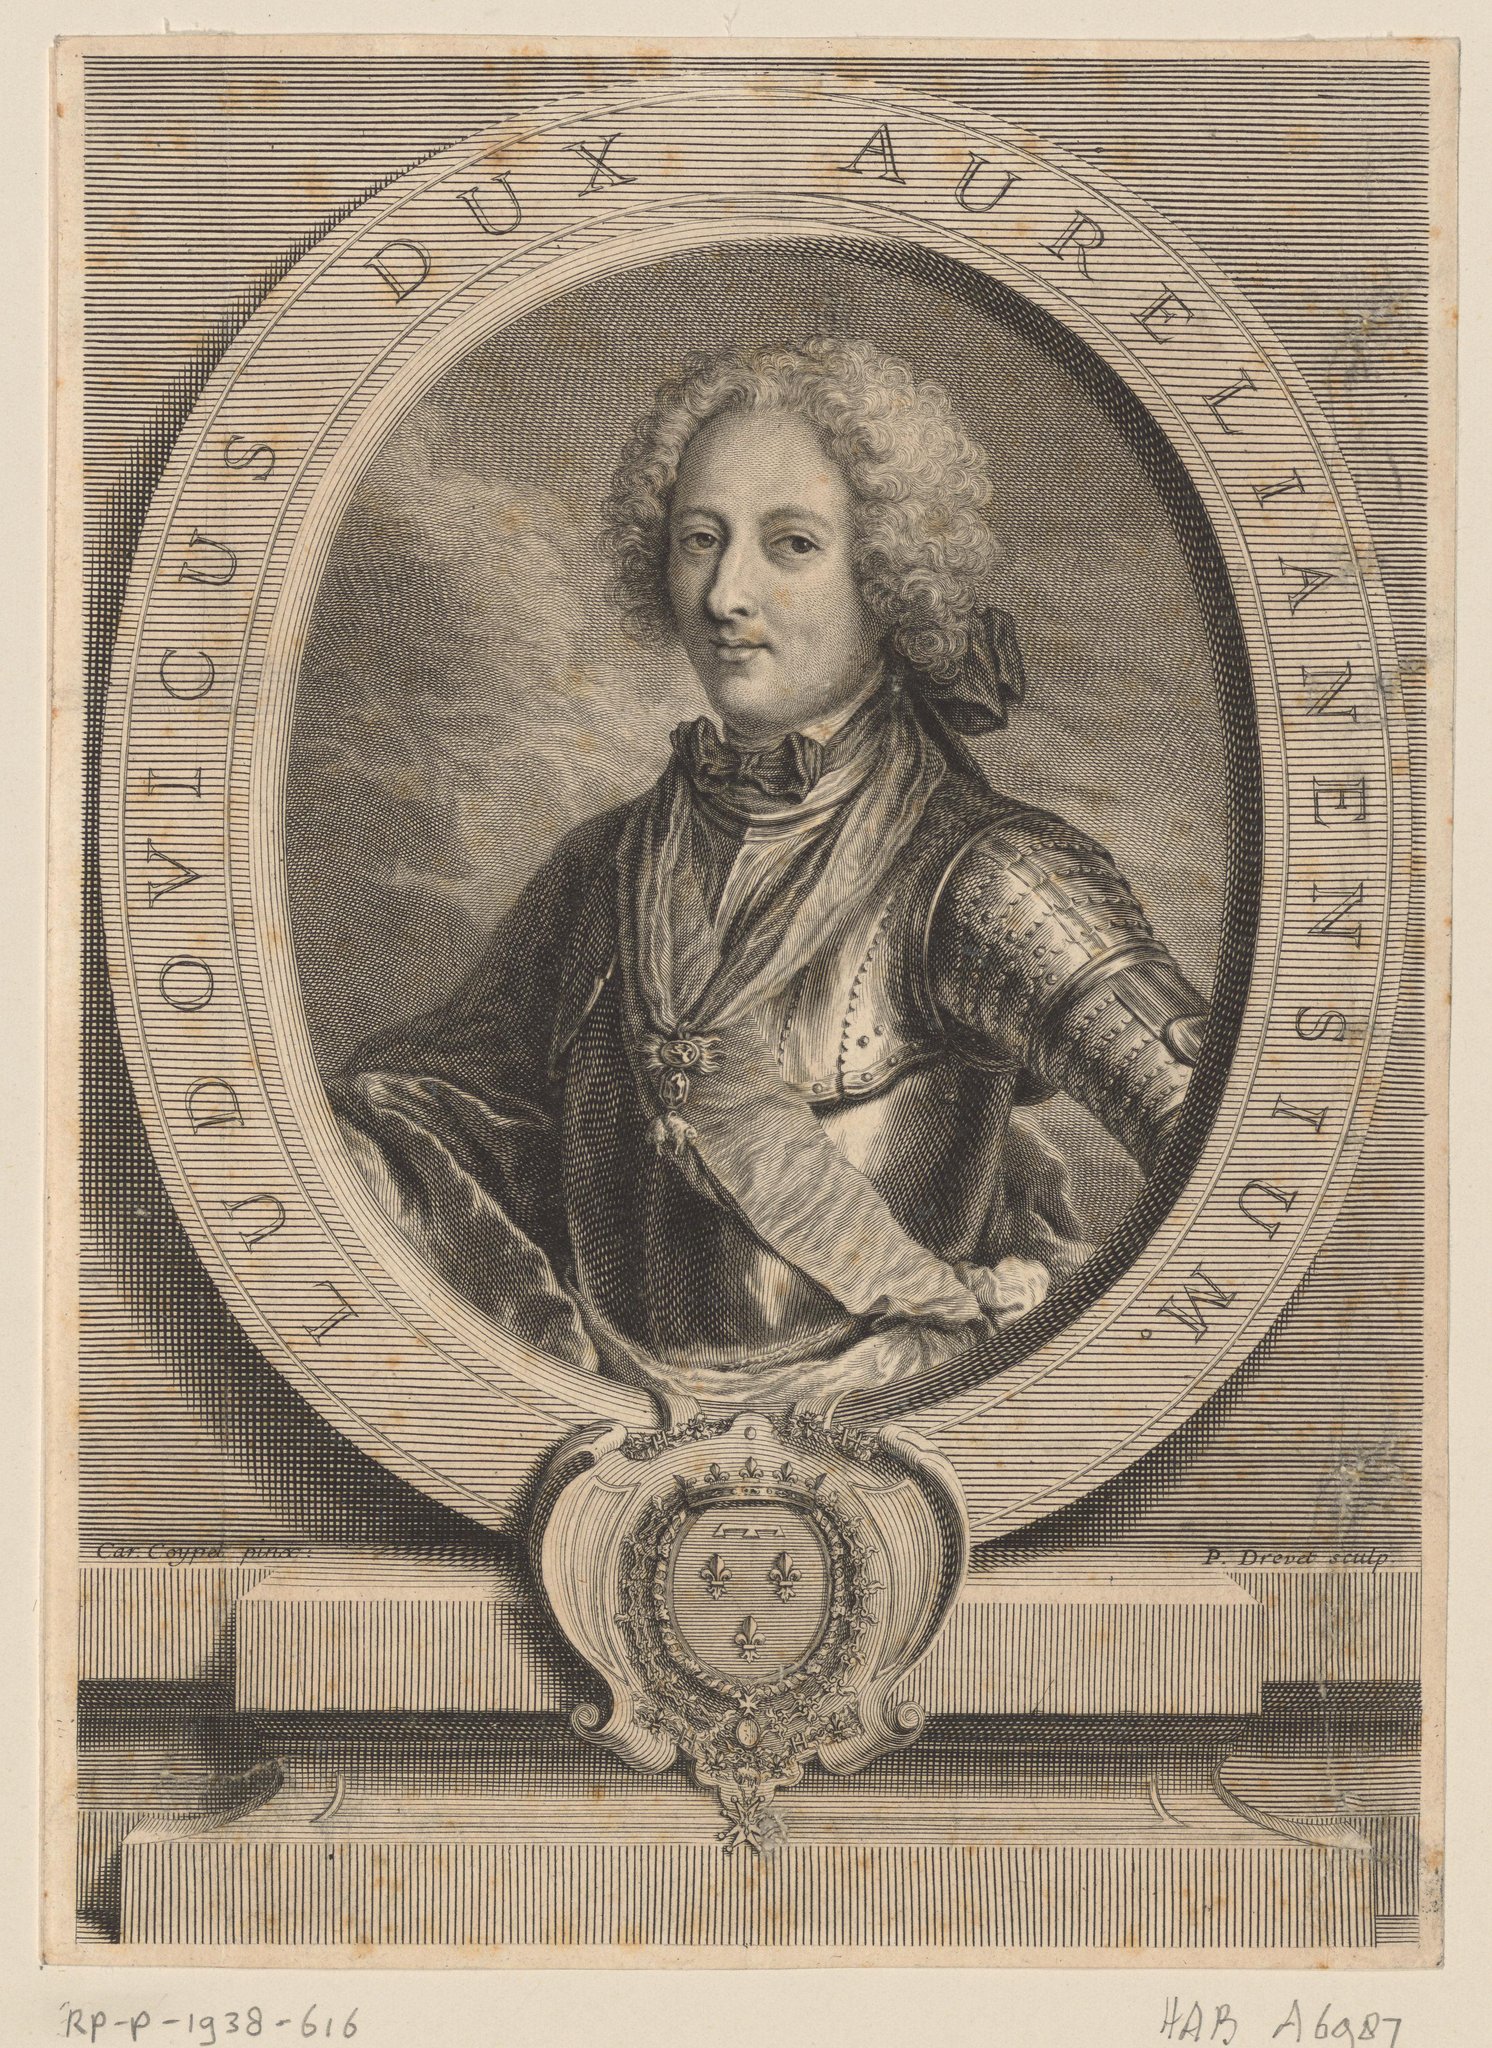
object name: print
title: Portret van Lodewijk van Orléans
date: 1723-1726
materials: paper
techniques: engraving, etching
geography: france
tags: lodewijk van orléans, ornament ~ medallion, armour, historical persons, knighthood order of the golden fleece - insignia of a knighthood order, e.g.: badge, chain (with name of order), armorial bearing, heraldry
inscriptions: collector's mark: Lugt 2228, collector's mark: Lugt 2760